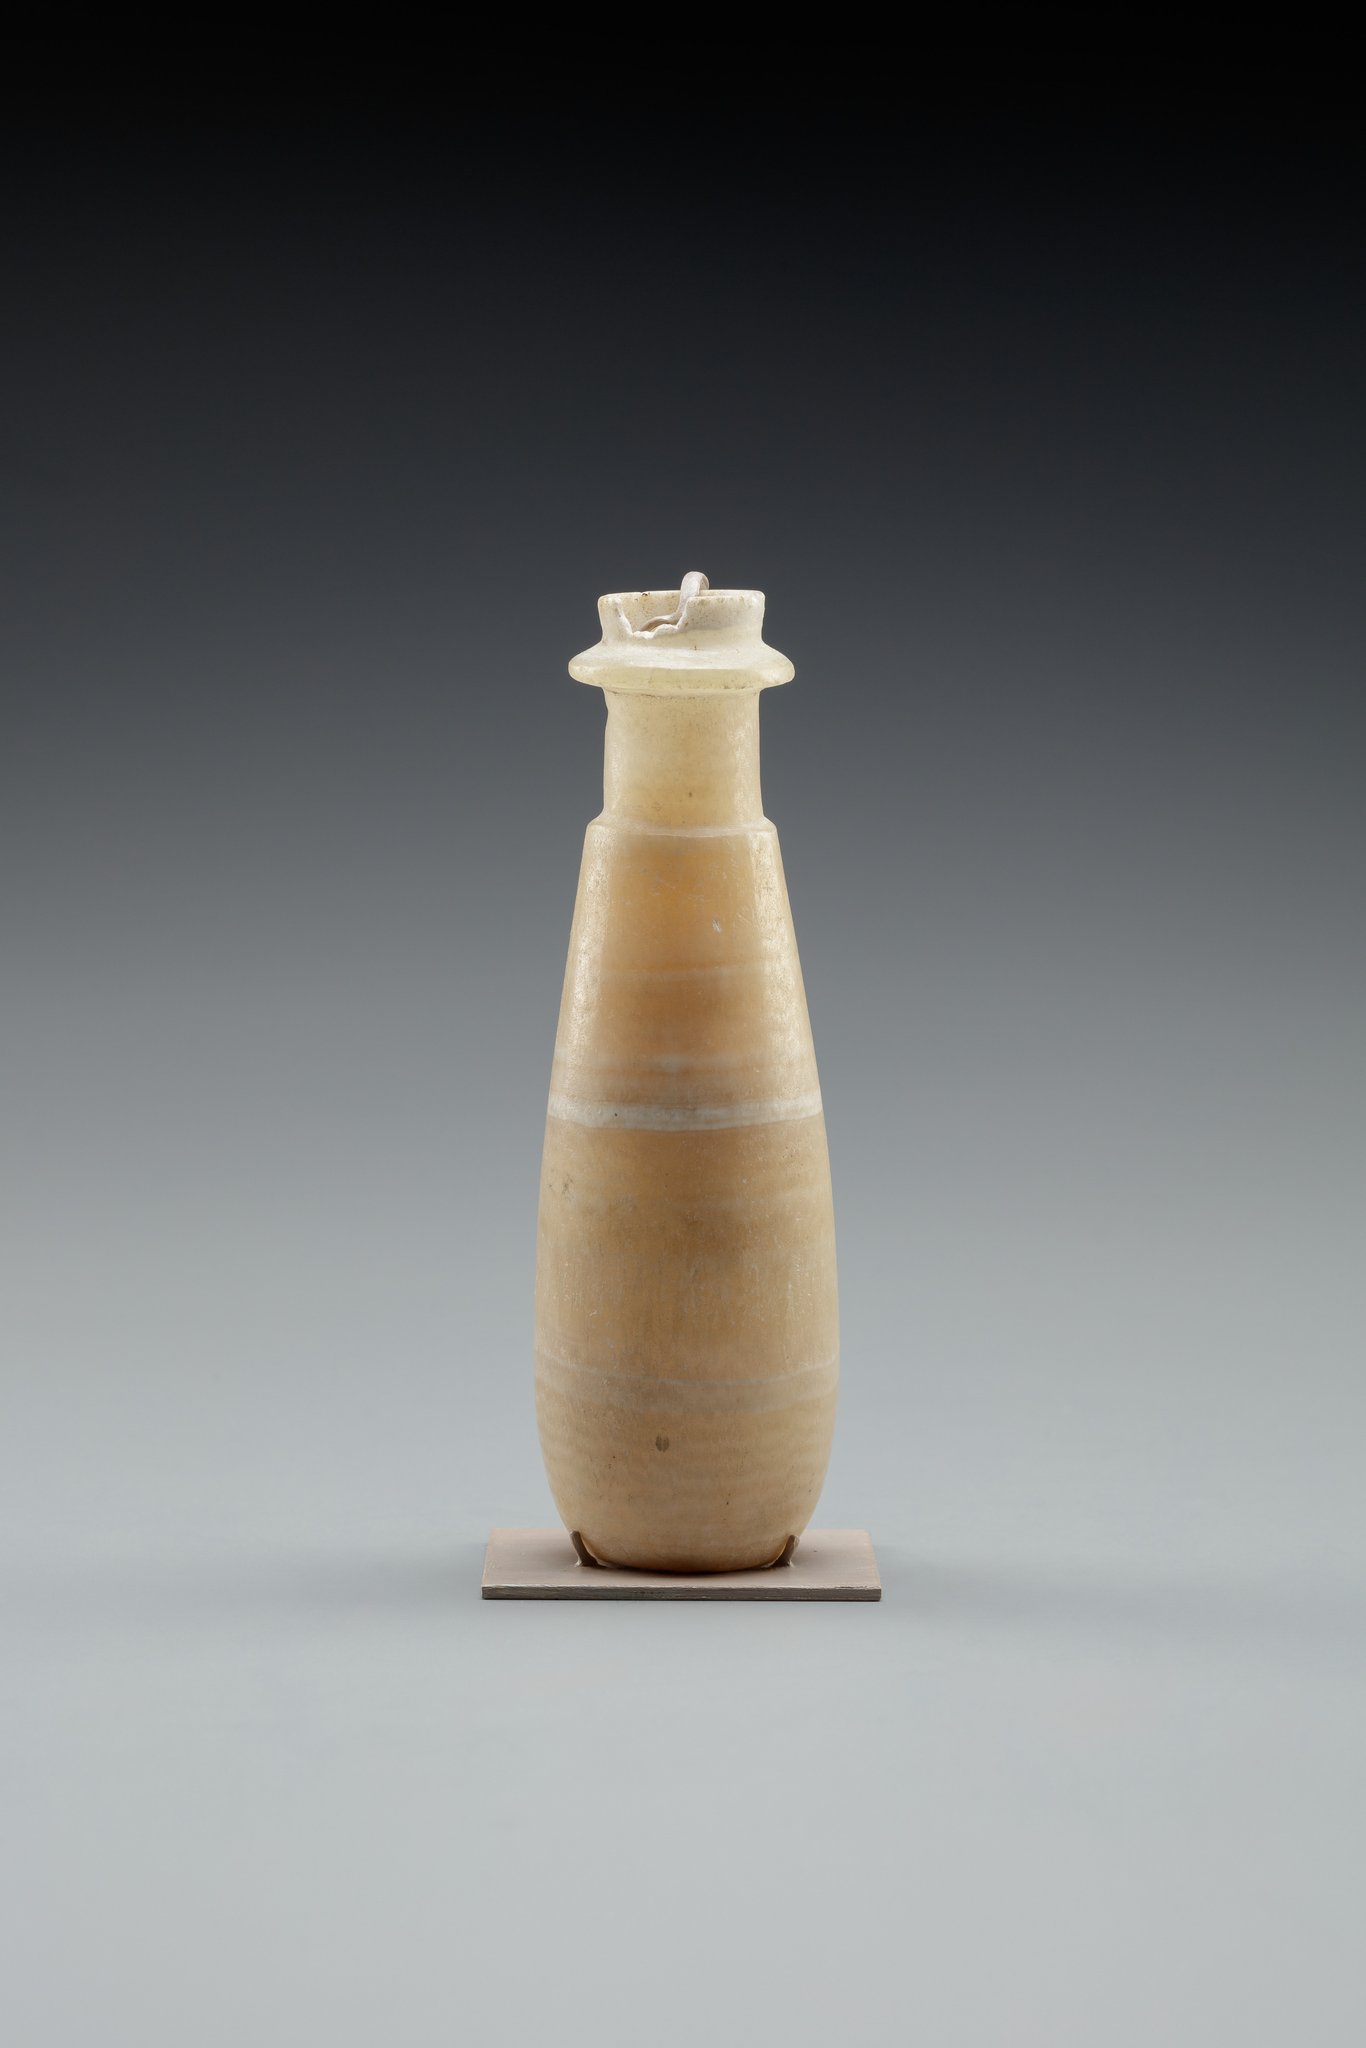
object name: vase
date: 664-332 BCE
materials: stone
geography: egypt